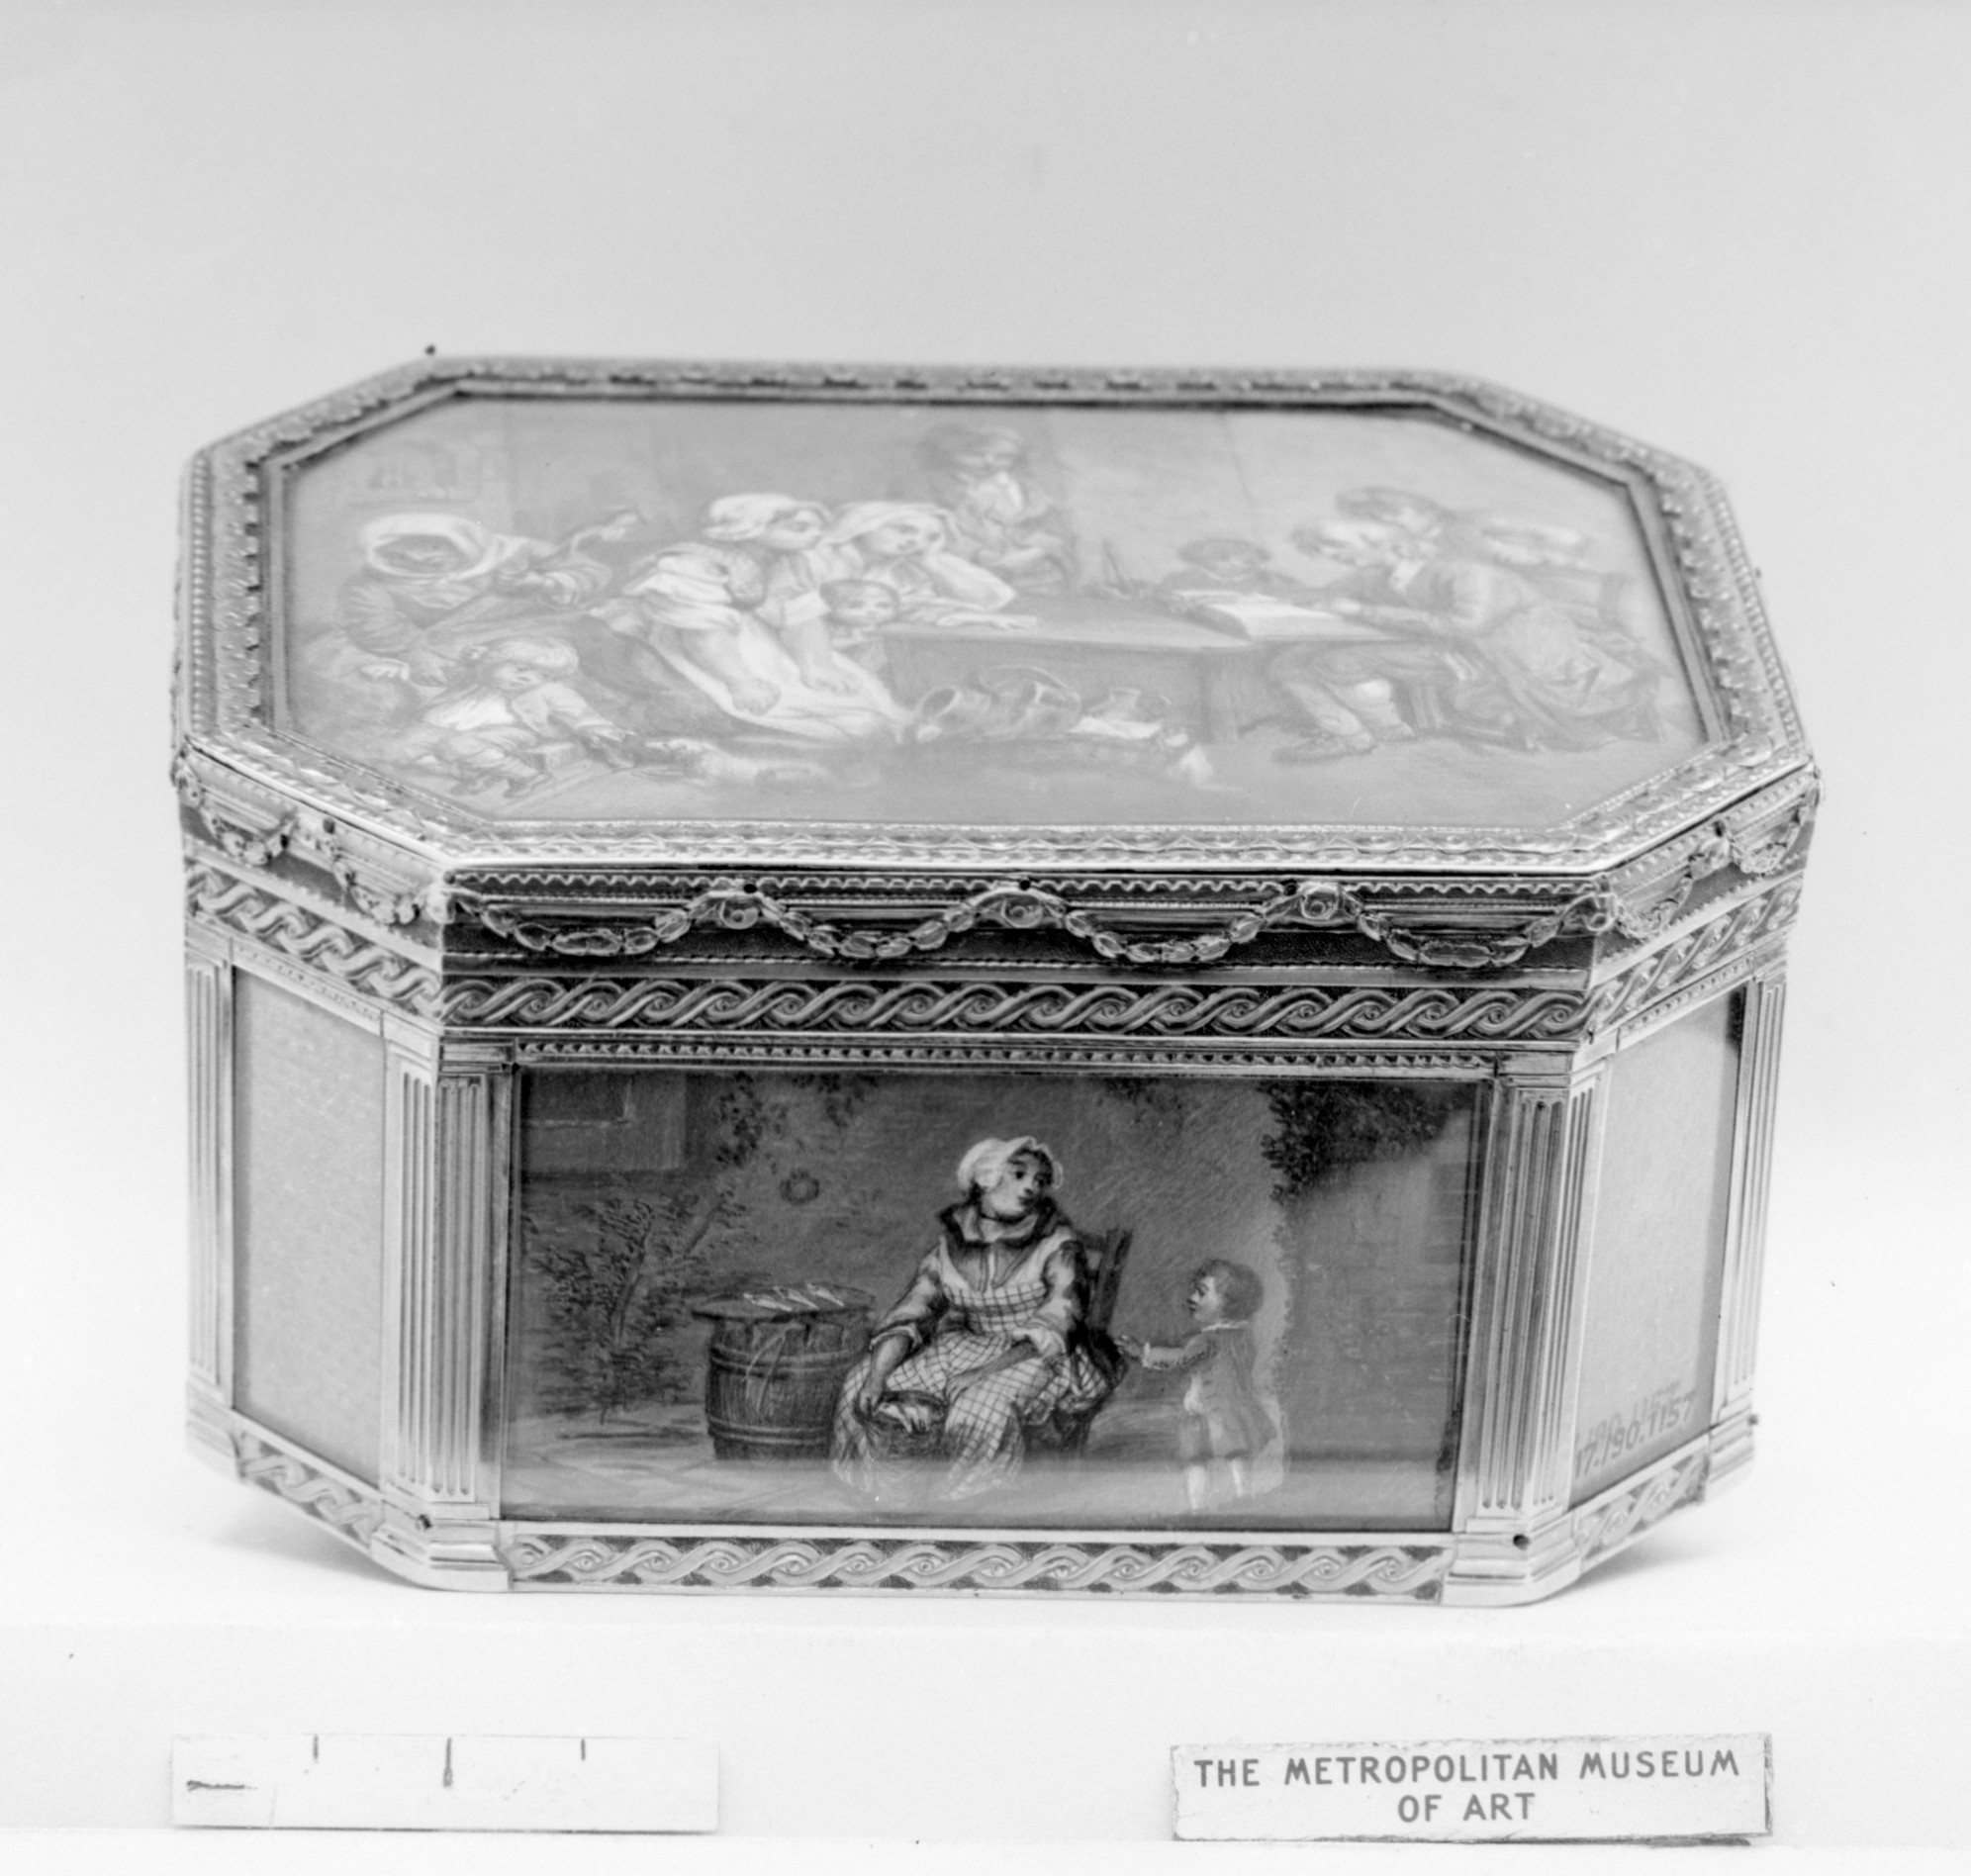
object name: snuffbox, painting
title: Snuffbox with household scenes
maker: jean-joseph barrière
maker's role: maker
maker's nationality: french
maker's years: 1733-1833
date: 1769-1770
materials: gold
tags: children,men,women,genre scene